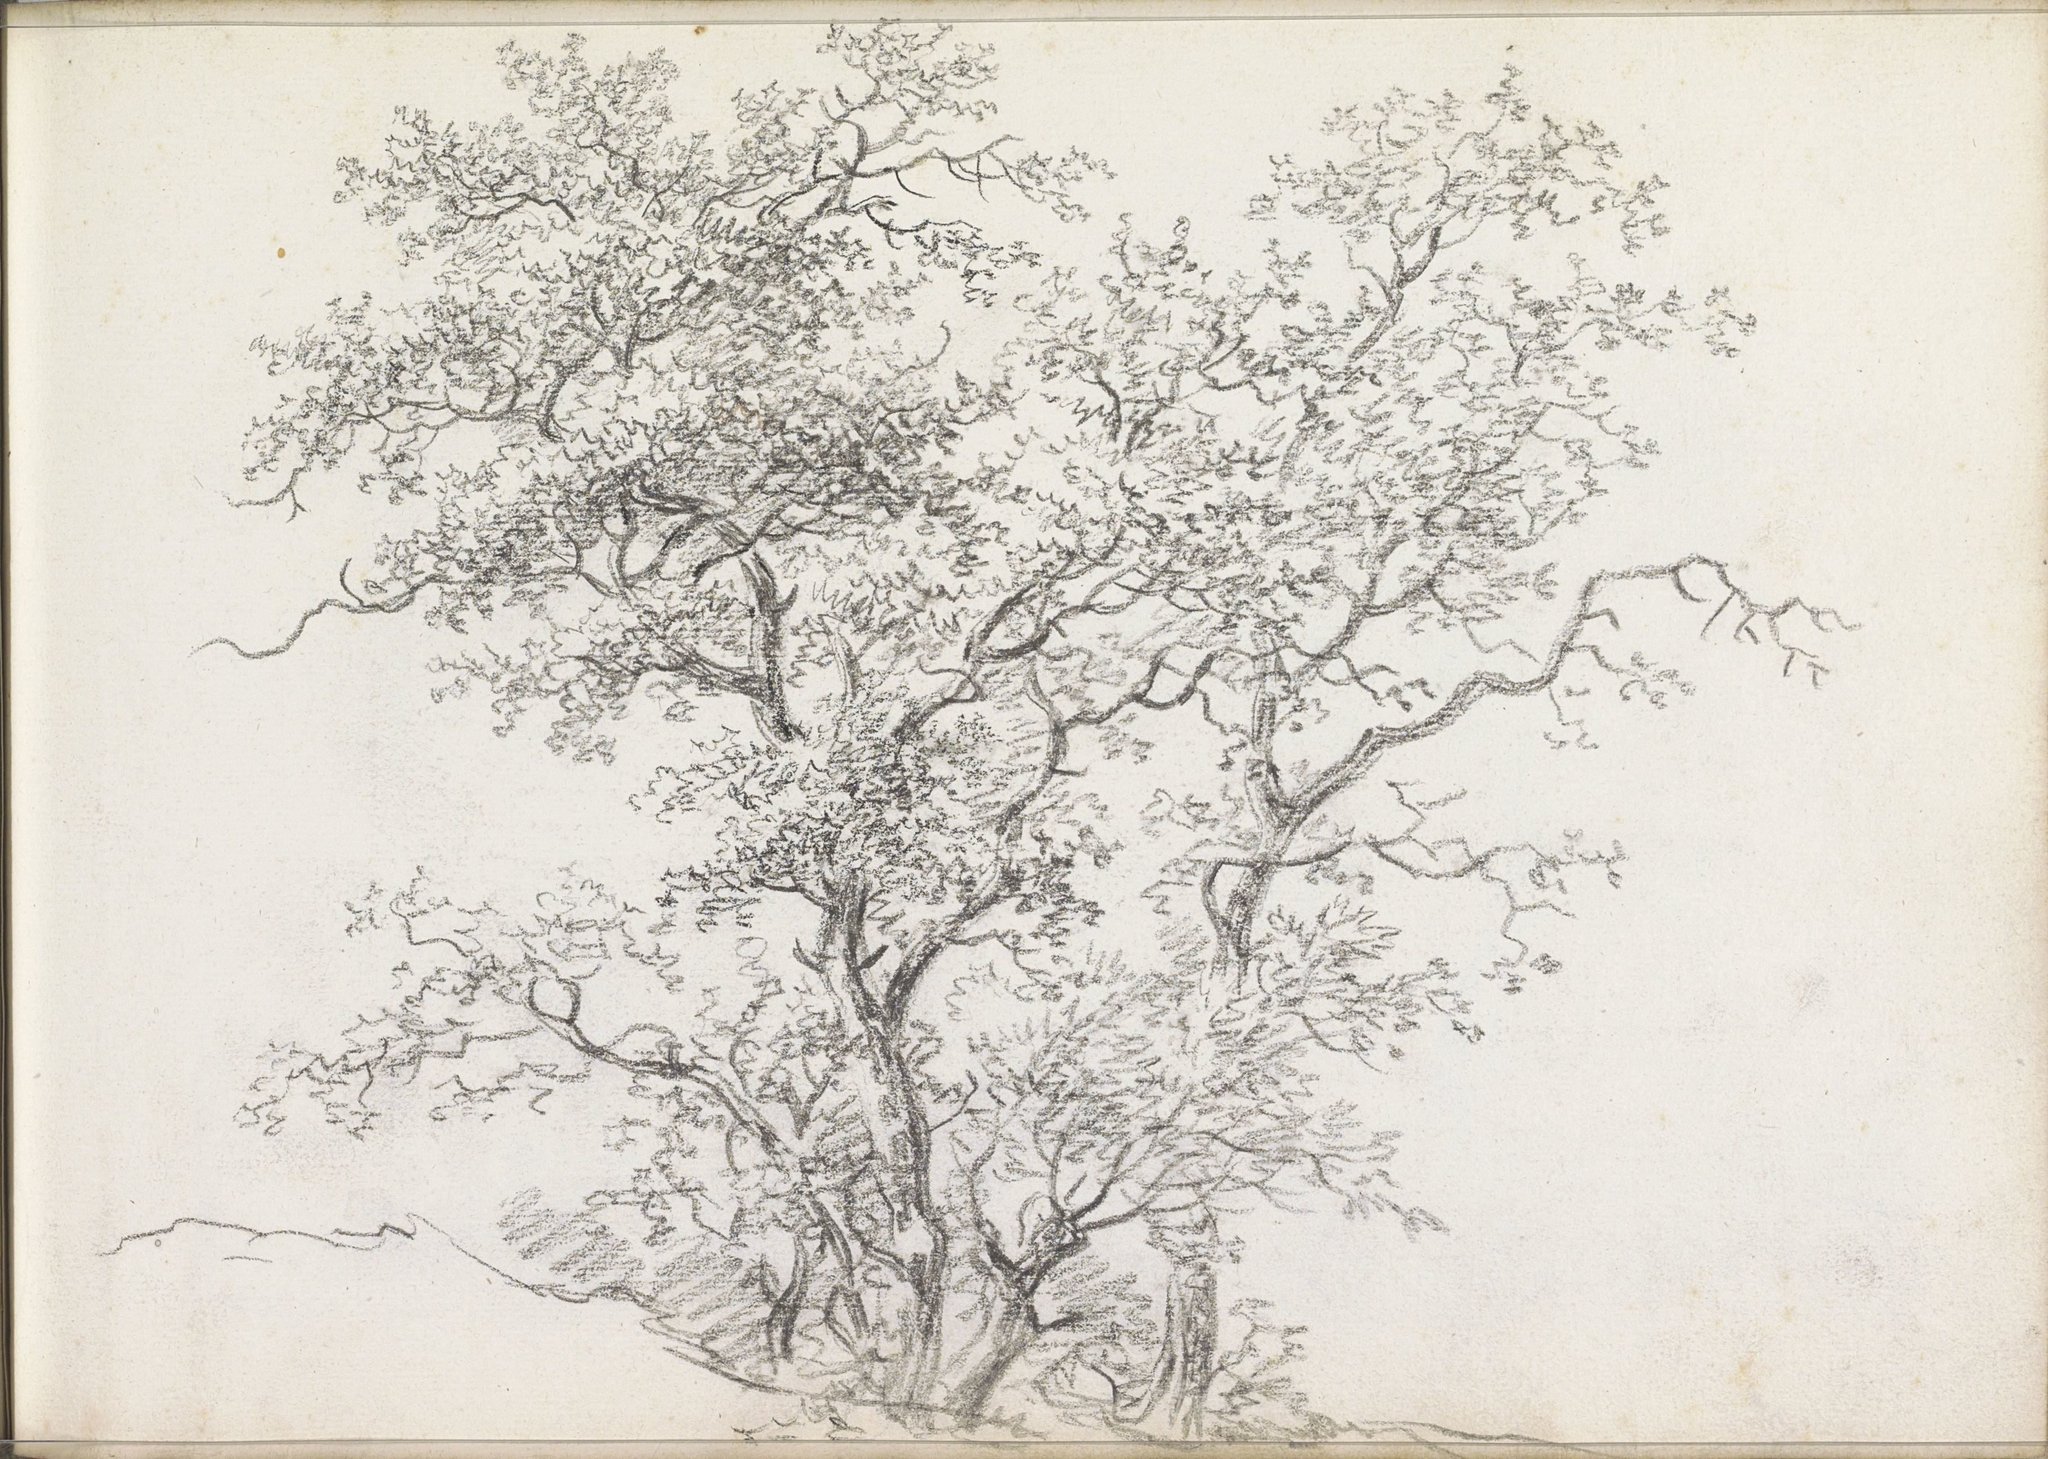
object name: sketchbook leaf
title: Bomen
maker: andreas schelfhout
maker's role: draughtsman, painter, print maker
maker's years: 1787-1870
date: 1811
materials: chalk, paper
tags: trees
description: Blad 51 recto uit een schetsboek met 75 bladen.